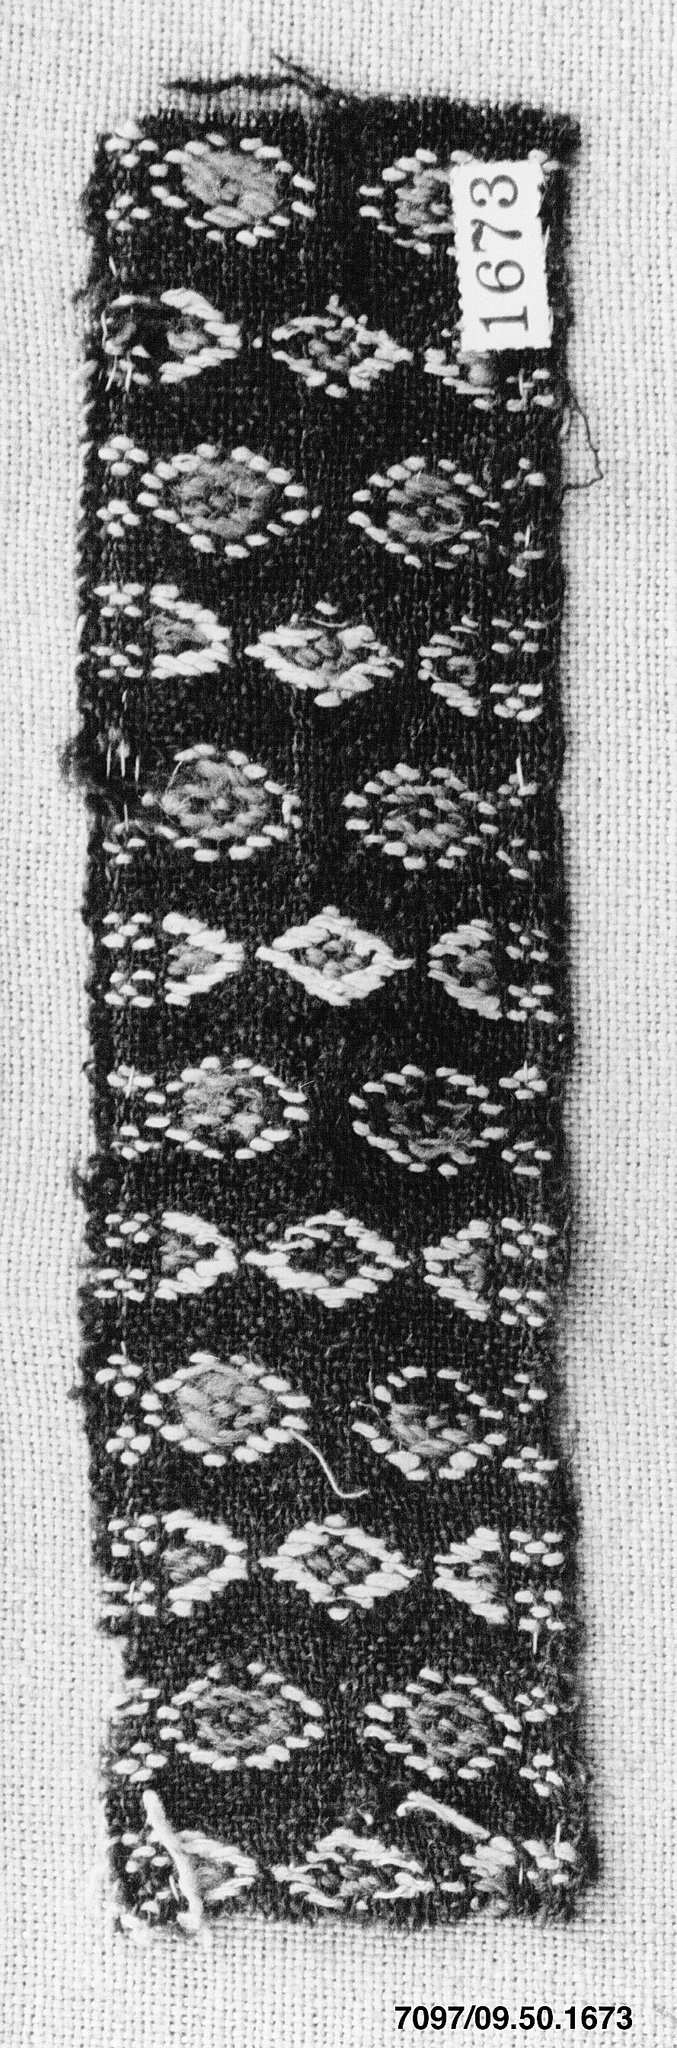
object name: fragment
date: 1801-1900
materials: linen, wool